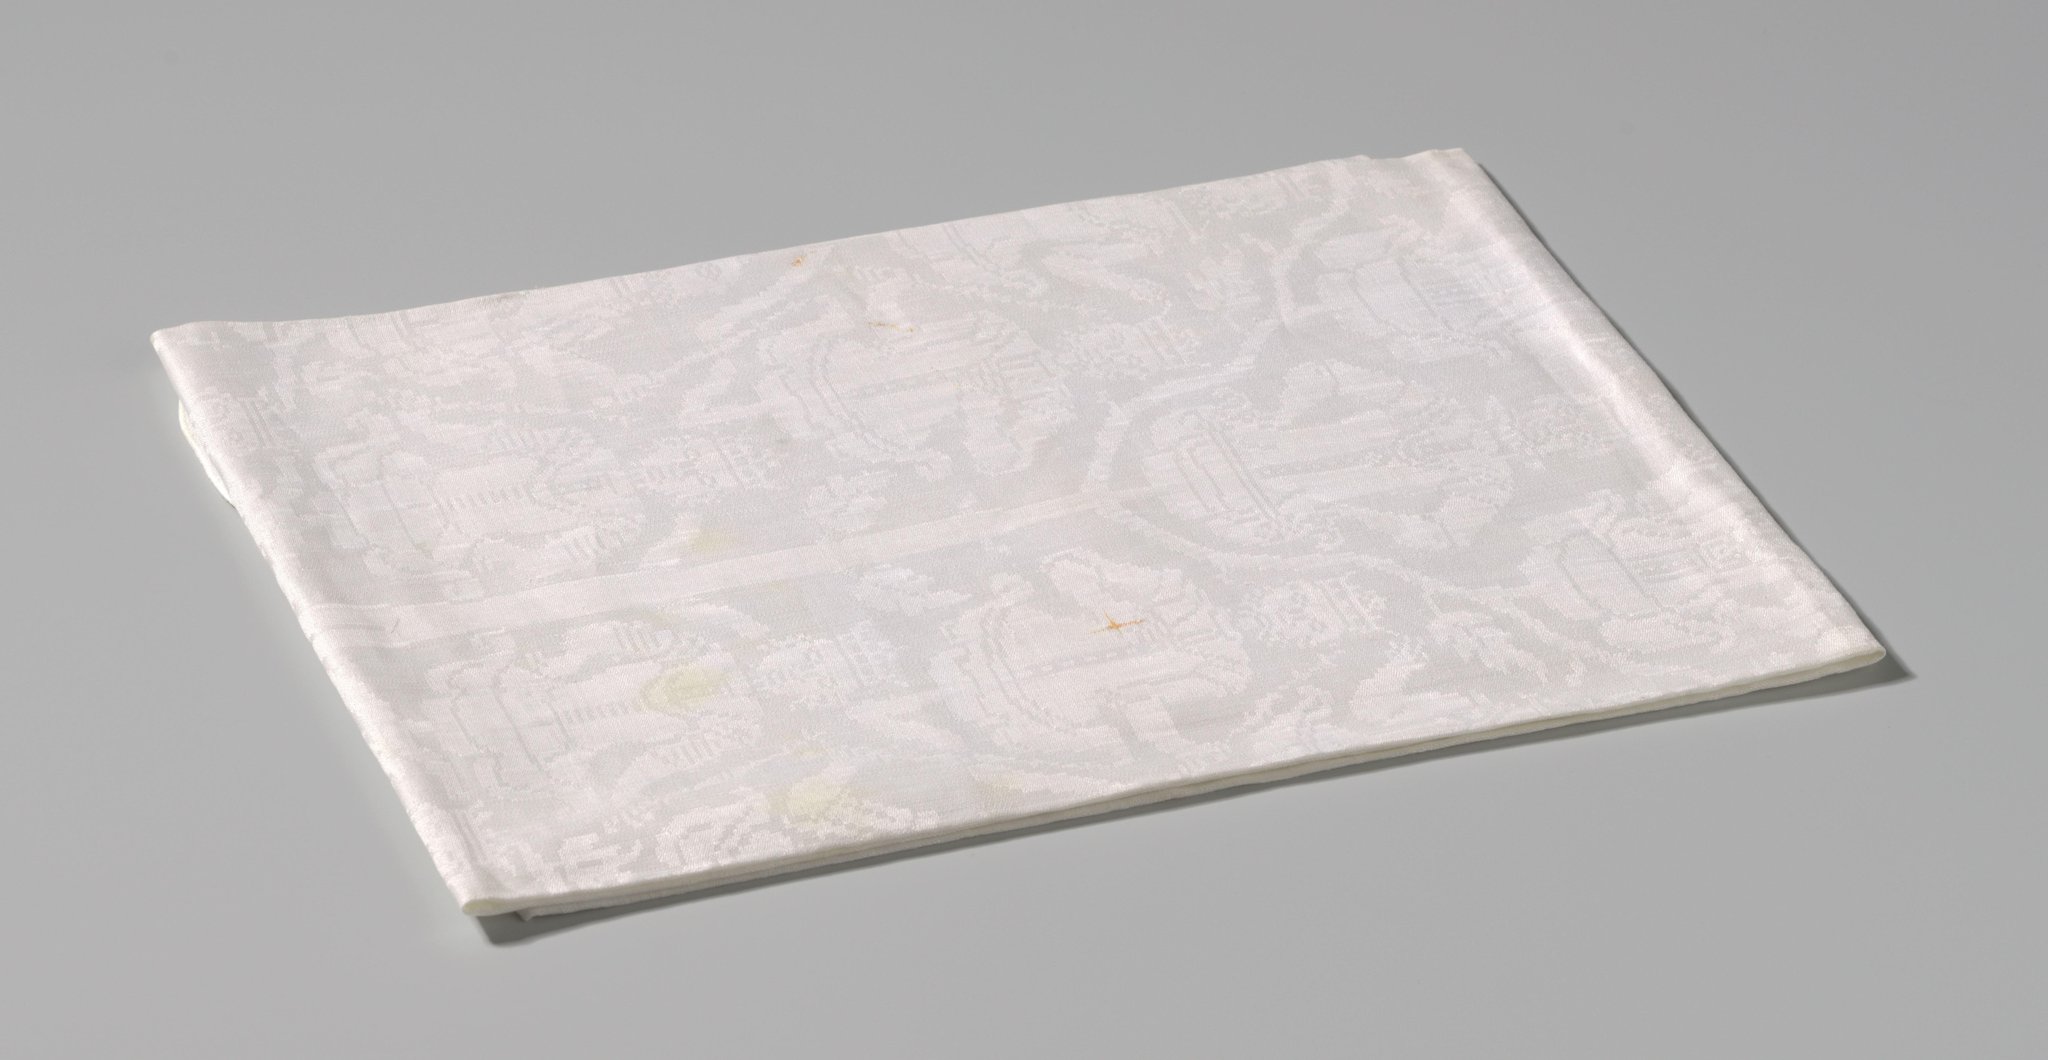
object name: napkin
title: Servet van linnendamast met de boom van Jesse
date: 1600-1625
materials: linen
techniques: damask, weave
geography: netherlands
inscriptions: mark: ‘KH 18’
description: Wit linnendamasten servet met de boom van Jesse. Het servet hoort bij vijf gelijke servetten (BK-1966-145-A t/m BK-1966-145-F).